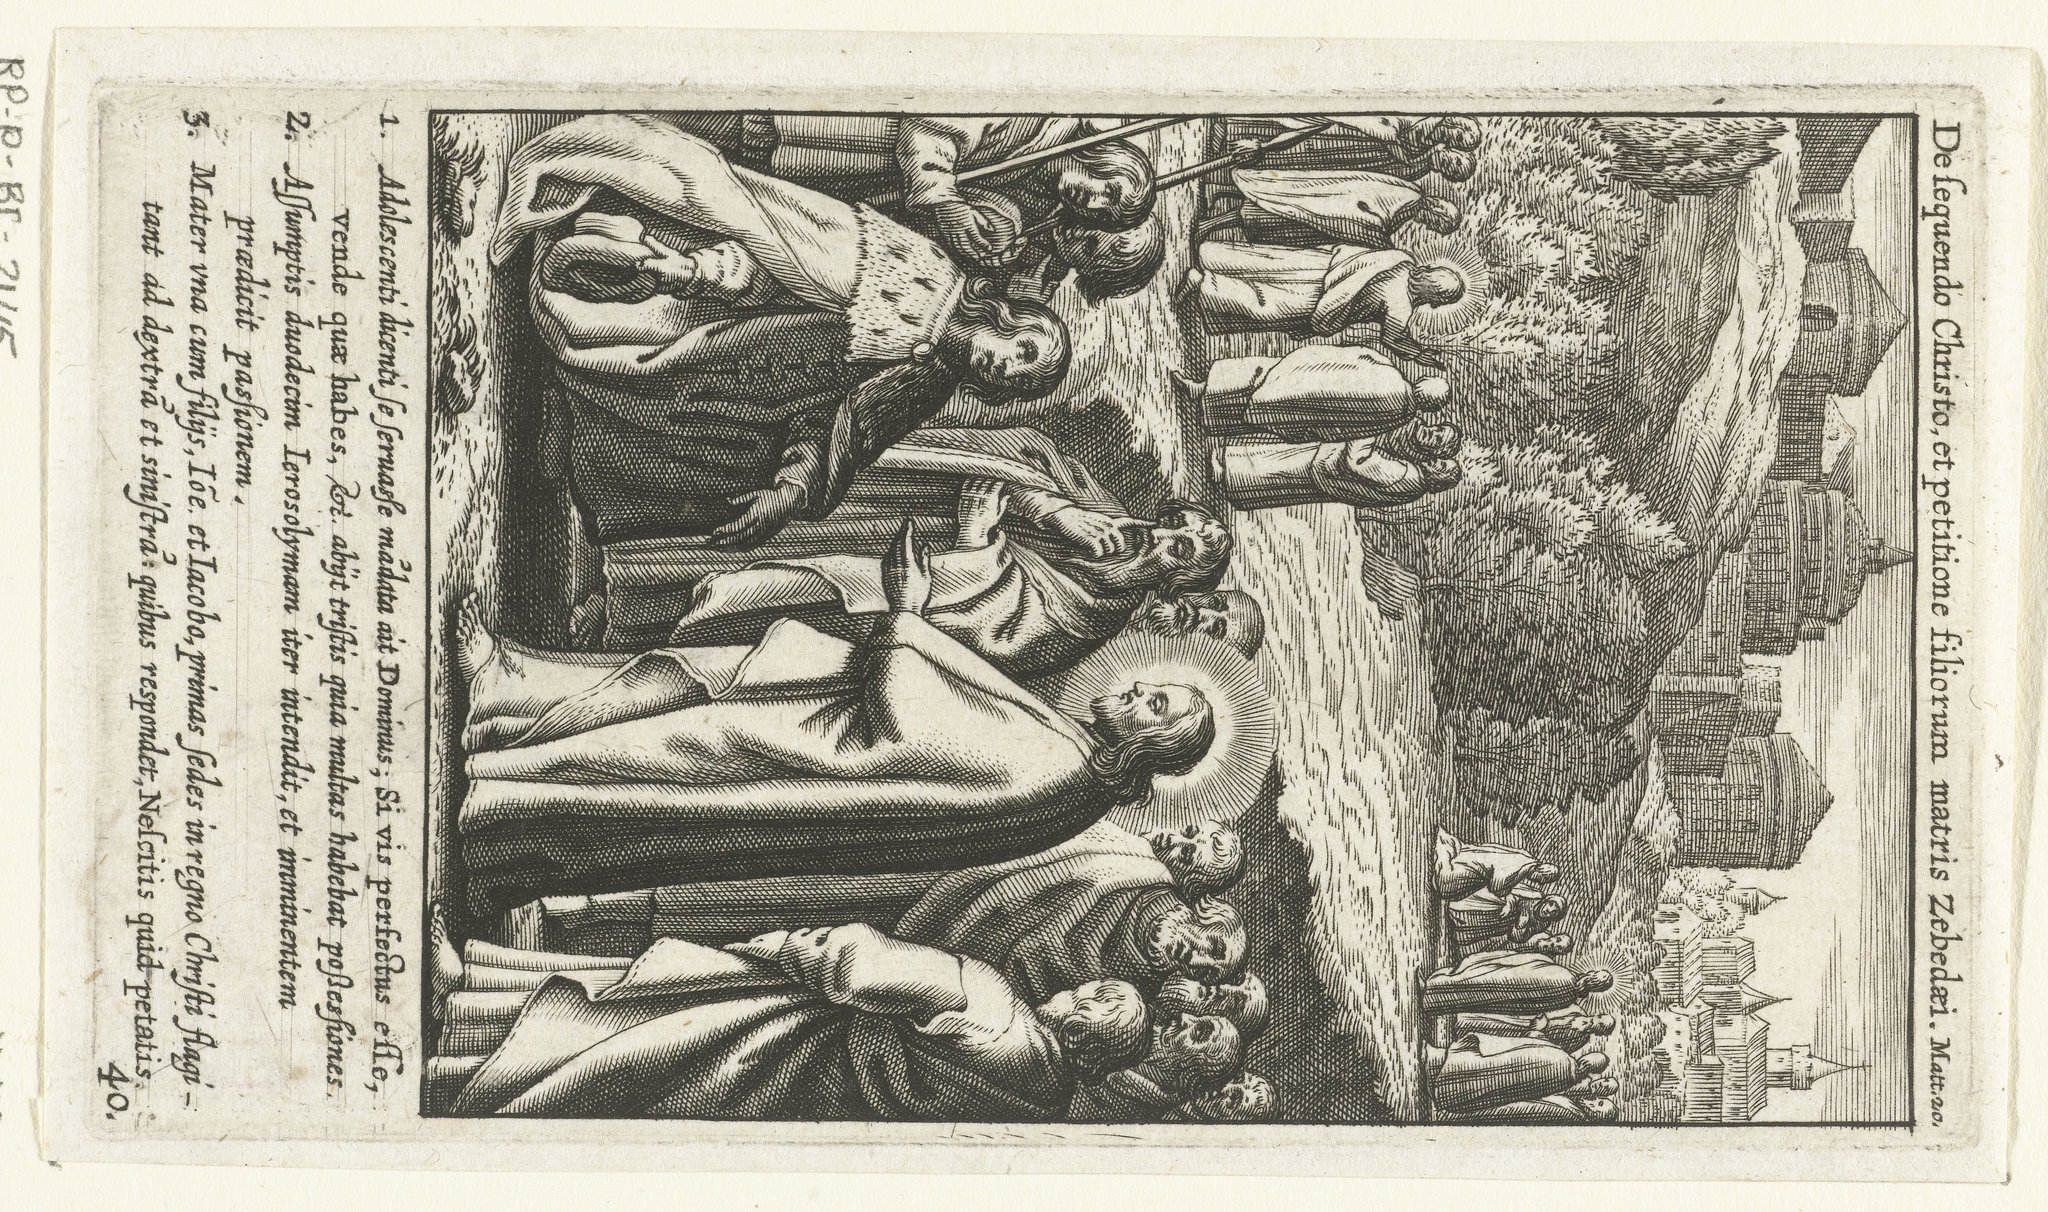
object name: print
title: De sequendo Christo et petitione filiorum matris Zebedaei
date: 1590-1622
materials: paper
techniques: engraving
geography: antwerp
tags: request of the mother of the sons of zebedee (matthew 20:20-21)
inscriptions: collector's mark: Lugt 240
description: Christus en de moeder van de zonen van Zebedeüs. De vrouw knielt voor Christus en vraagt hem of haar twee zonen links en rechts naast hem mogen zitten in zijn koninkrijk. Vooraan: scène met de rijke jongeling (Mattheüs 19:16 e.v.)